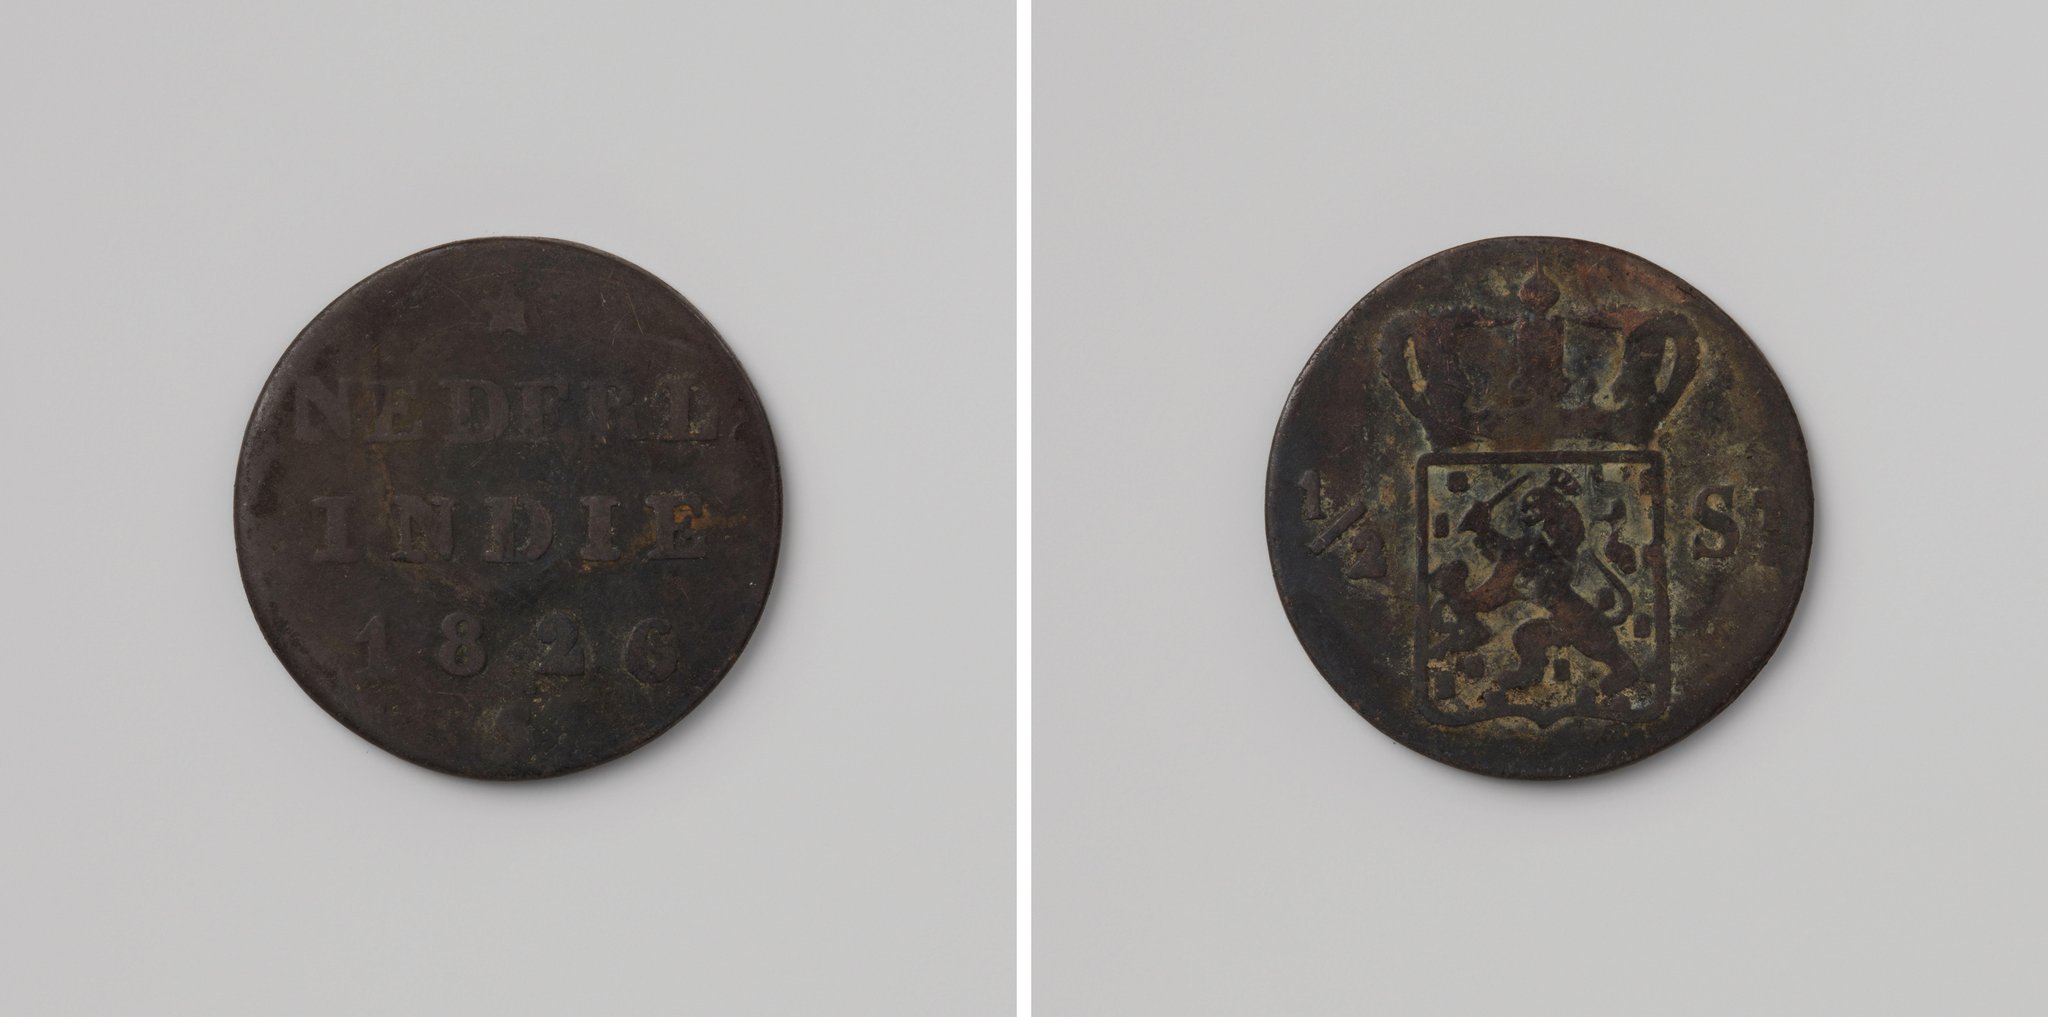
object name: coin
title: 1/2 VOC-stuiver van koper uit 1826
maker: Anonymous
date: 1826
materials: copper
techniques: striking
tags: dutch east indies, the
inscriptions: inscription: ‘Jacques Schulman / Numismaat / Keizersgracht 448 / Amsterdam-C.’, inscription: ‘NEDERL / INDIE / 1826 / S’, inscription: ‘1/2 St’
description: Koperen 1/2 stuiver van de VOC uit Nederlands-Indië uit 1826. Voorzijde: opschrift. Keerzijde: een gekroond wapen met leeuw erin en links ervan staat 1/2, rechts ervan staan de letters St. Het muntje zit in een vierkant envelopje met opschrift.